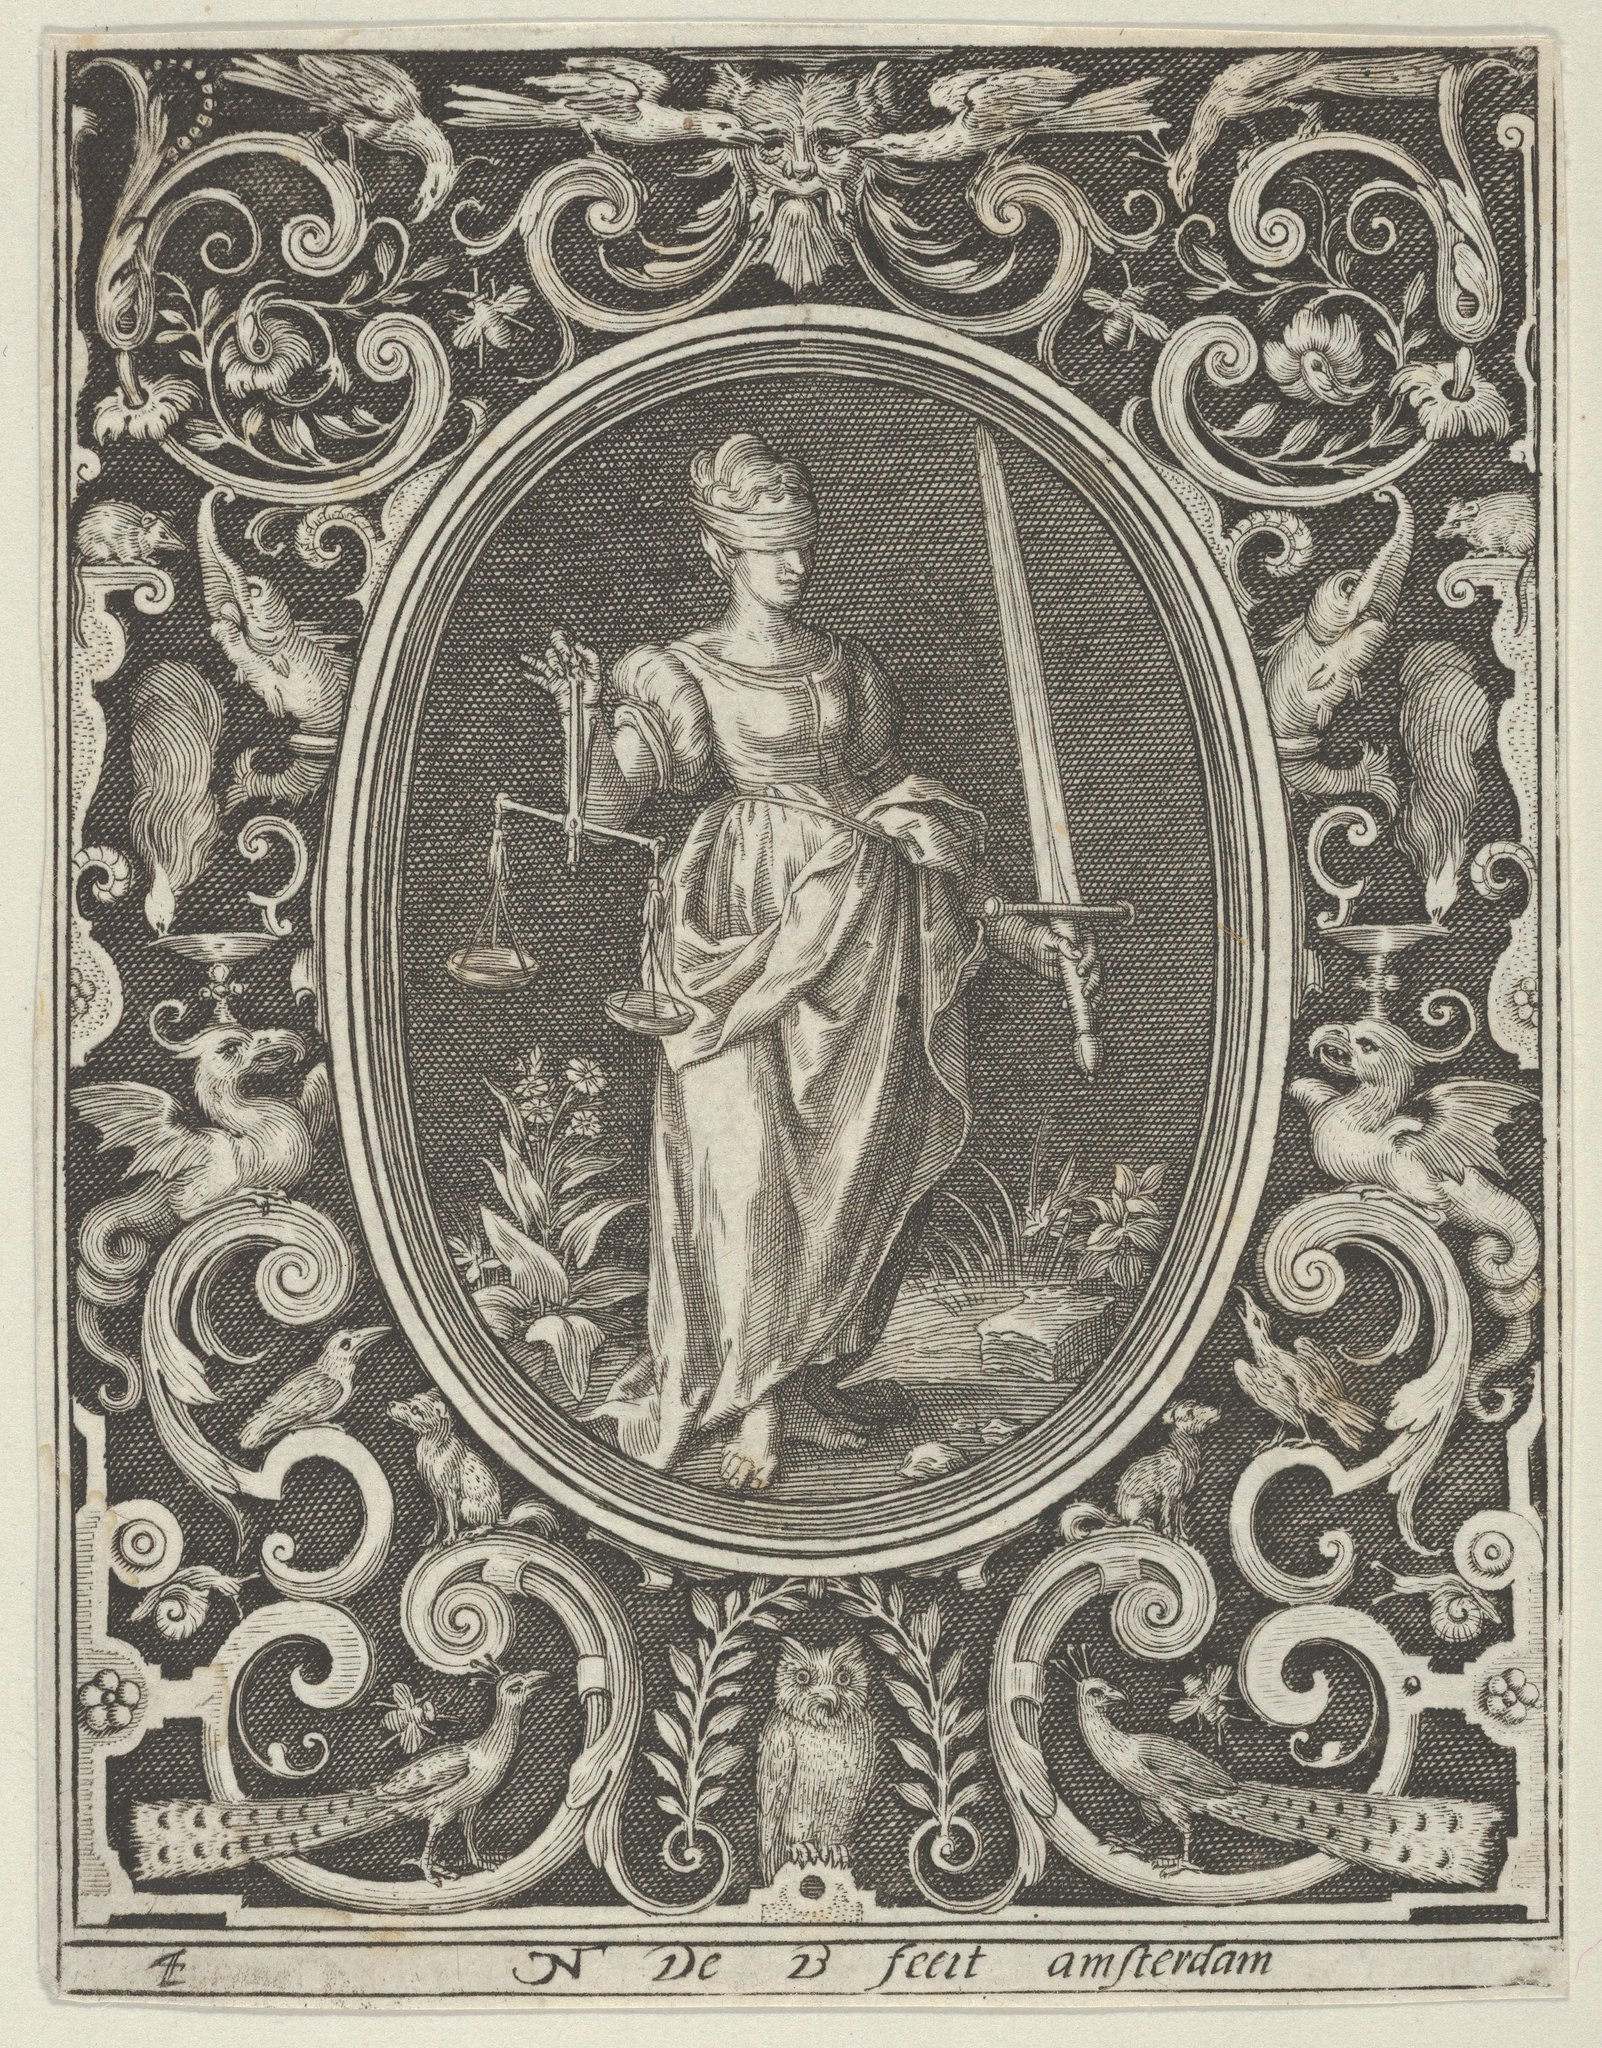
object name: print ornament architecture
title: Justice, from the Cardinal Virtues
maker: nicolaes de bruyn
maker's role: artist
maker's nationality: netherlandish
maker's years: 1571-1656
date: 1648-1656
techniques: engraving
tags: swords,women,peacocks,scales